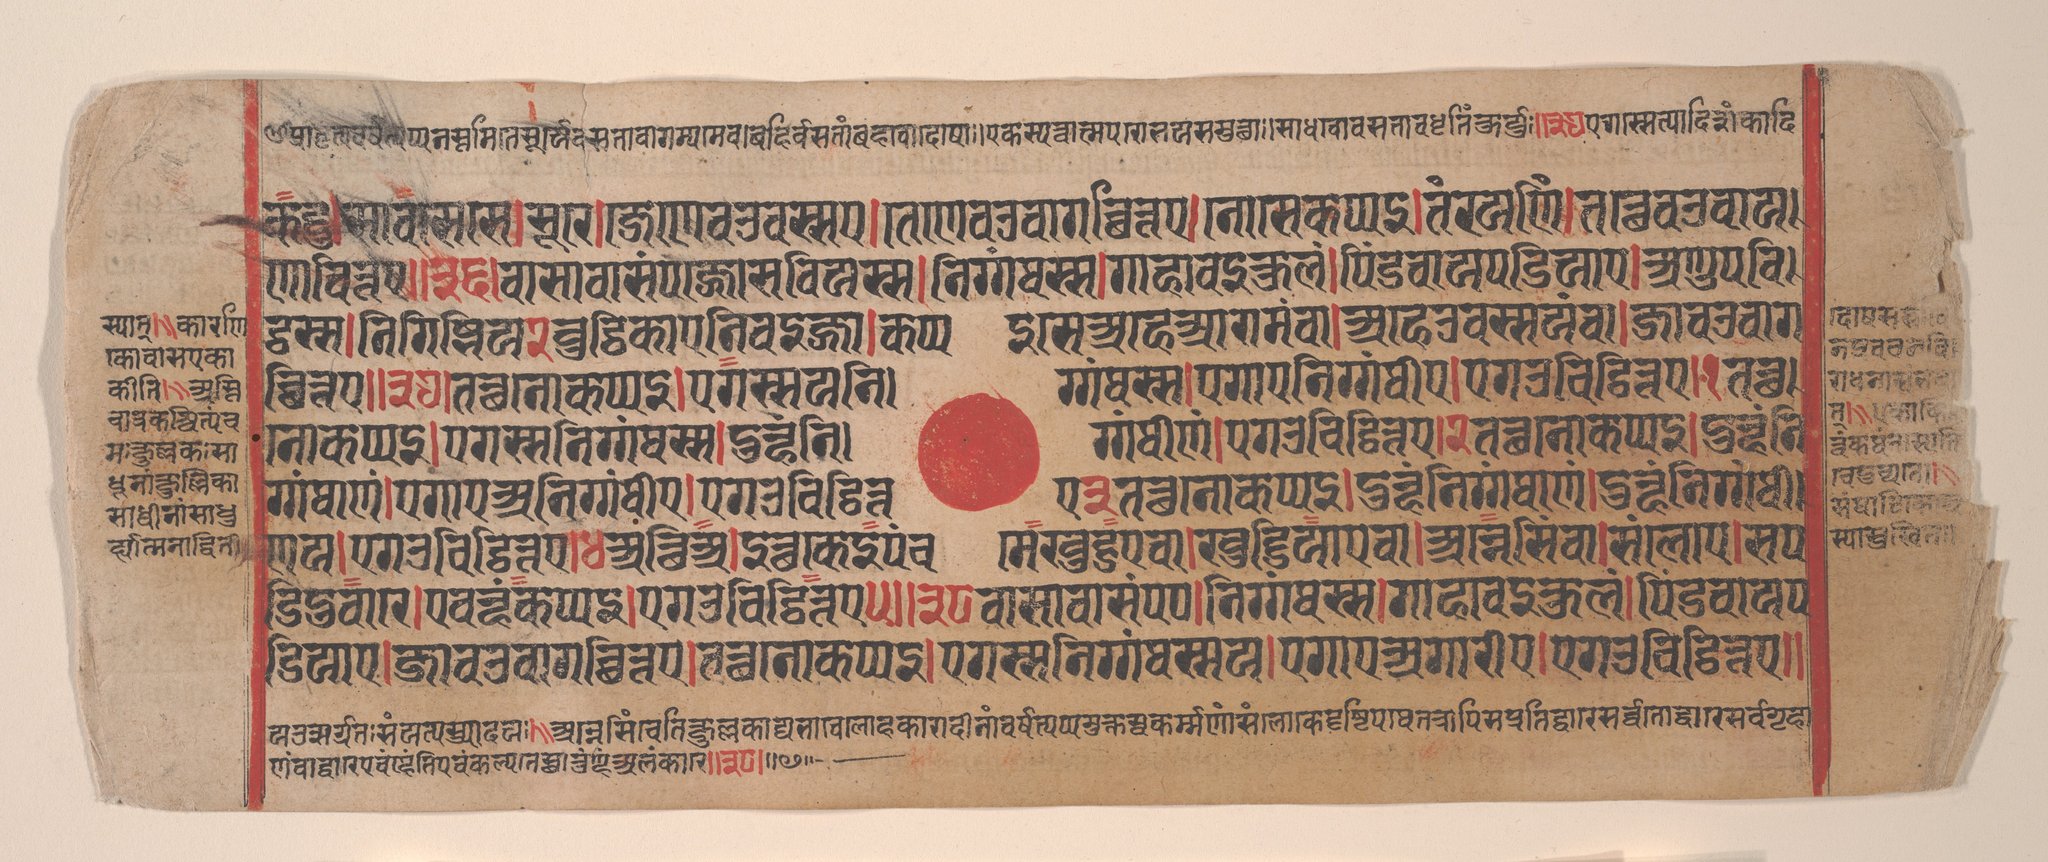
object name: folio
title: Leaf from a Kalpa Sutra (Jain Book of Rituals)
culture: indian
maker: bhadrabahu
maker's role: artist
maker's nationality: indian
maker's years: 356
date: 1401-1500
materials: gold, ink, paper, watercolor